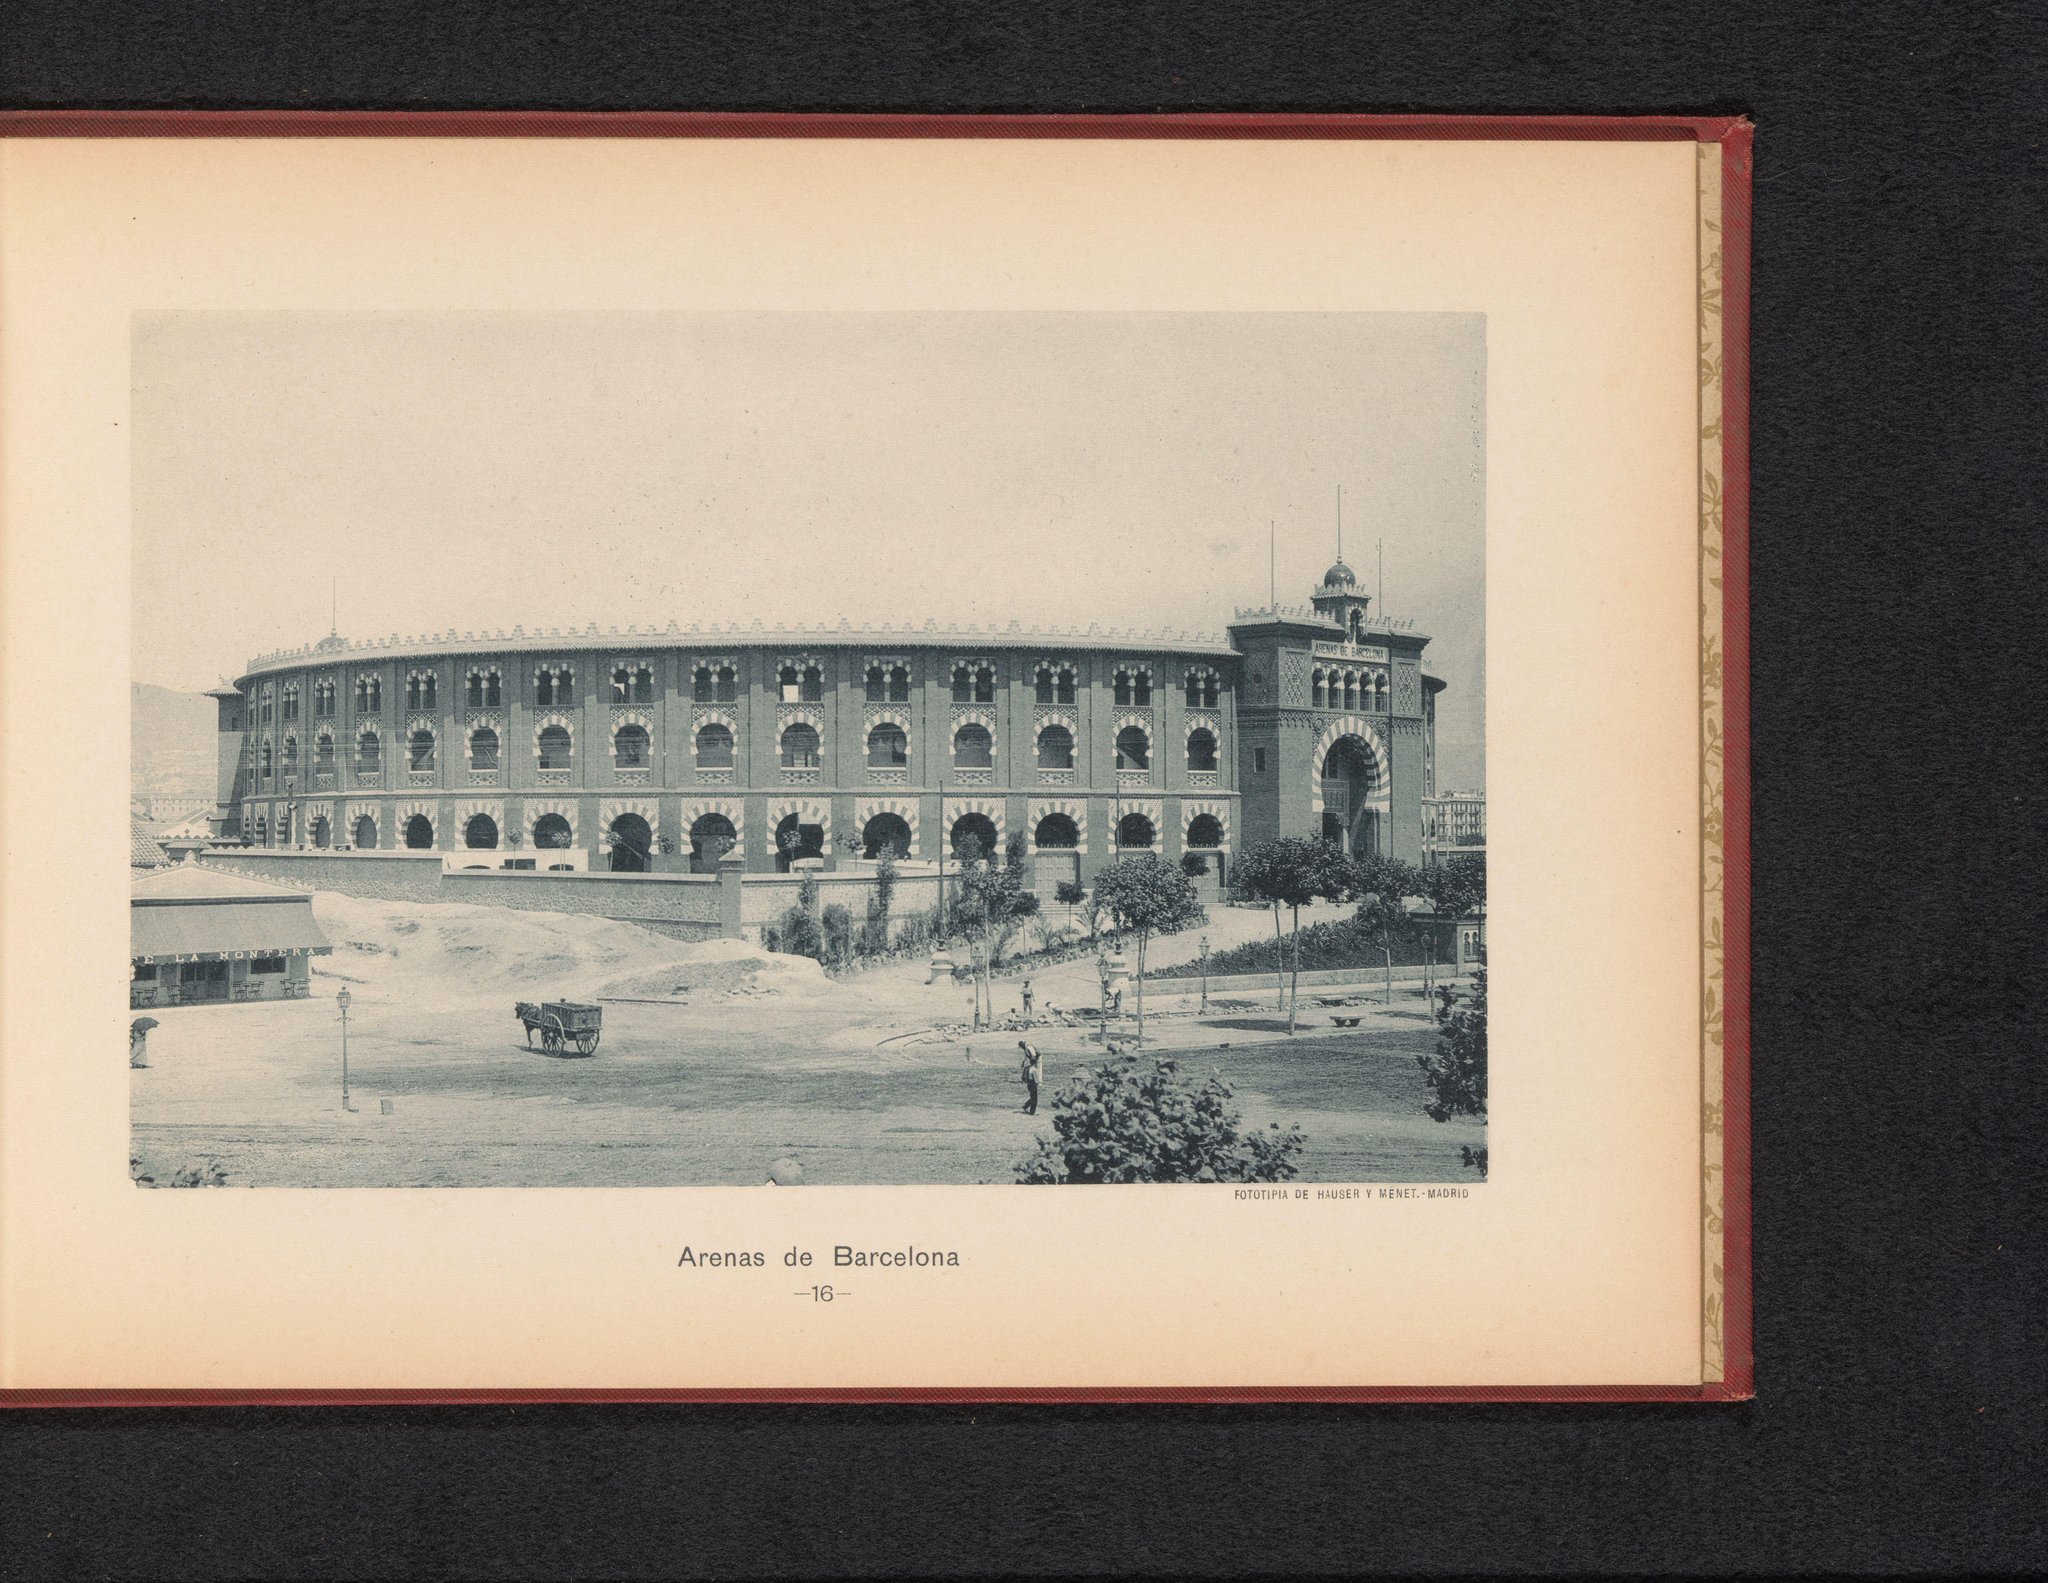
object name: page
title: Gezicht op Las Arenas in Barcelona in aanbouw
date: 1890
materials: paper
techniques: photograph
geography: barcelona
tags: grounds, fields and accomodations for sports, games and physical performances (+ out of doors (sports, games, etc.)), building-site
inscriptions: number: ‘-16-’